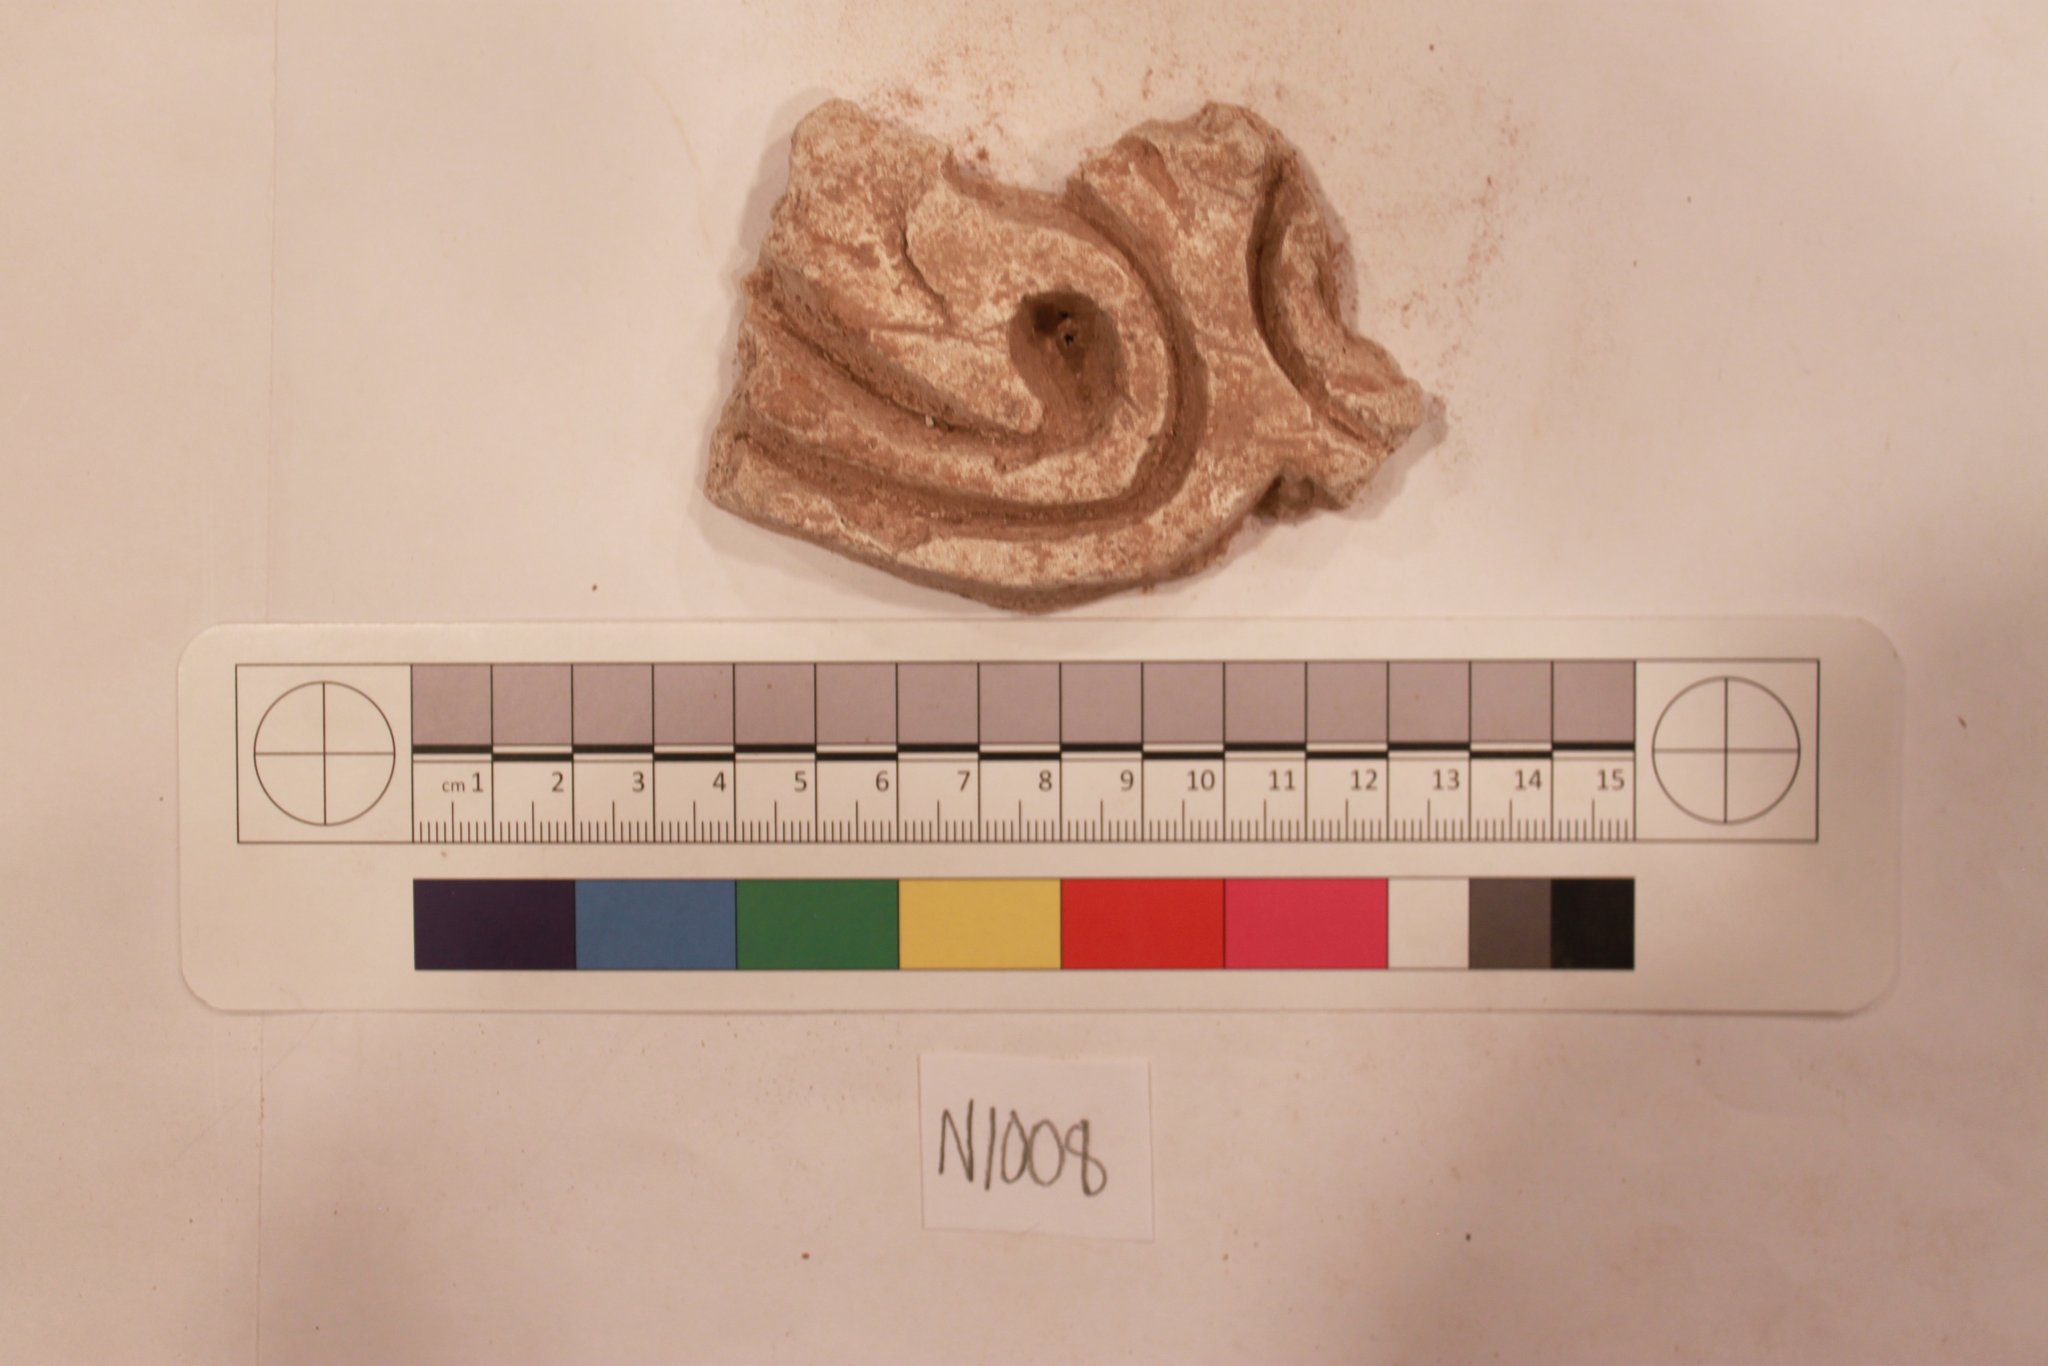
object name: fragment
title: Stucco Fragment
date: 701-1200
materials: plaster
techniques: carving, painting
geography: iran